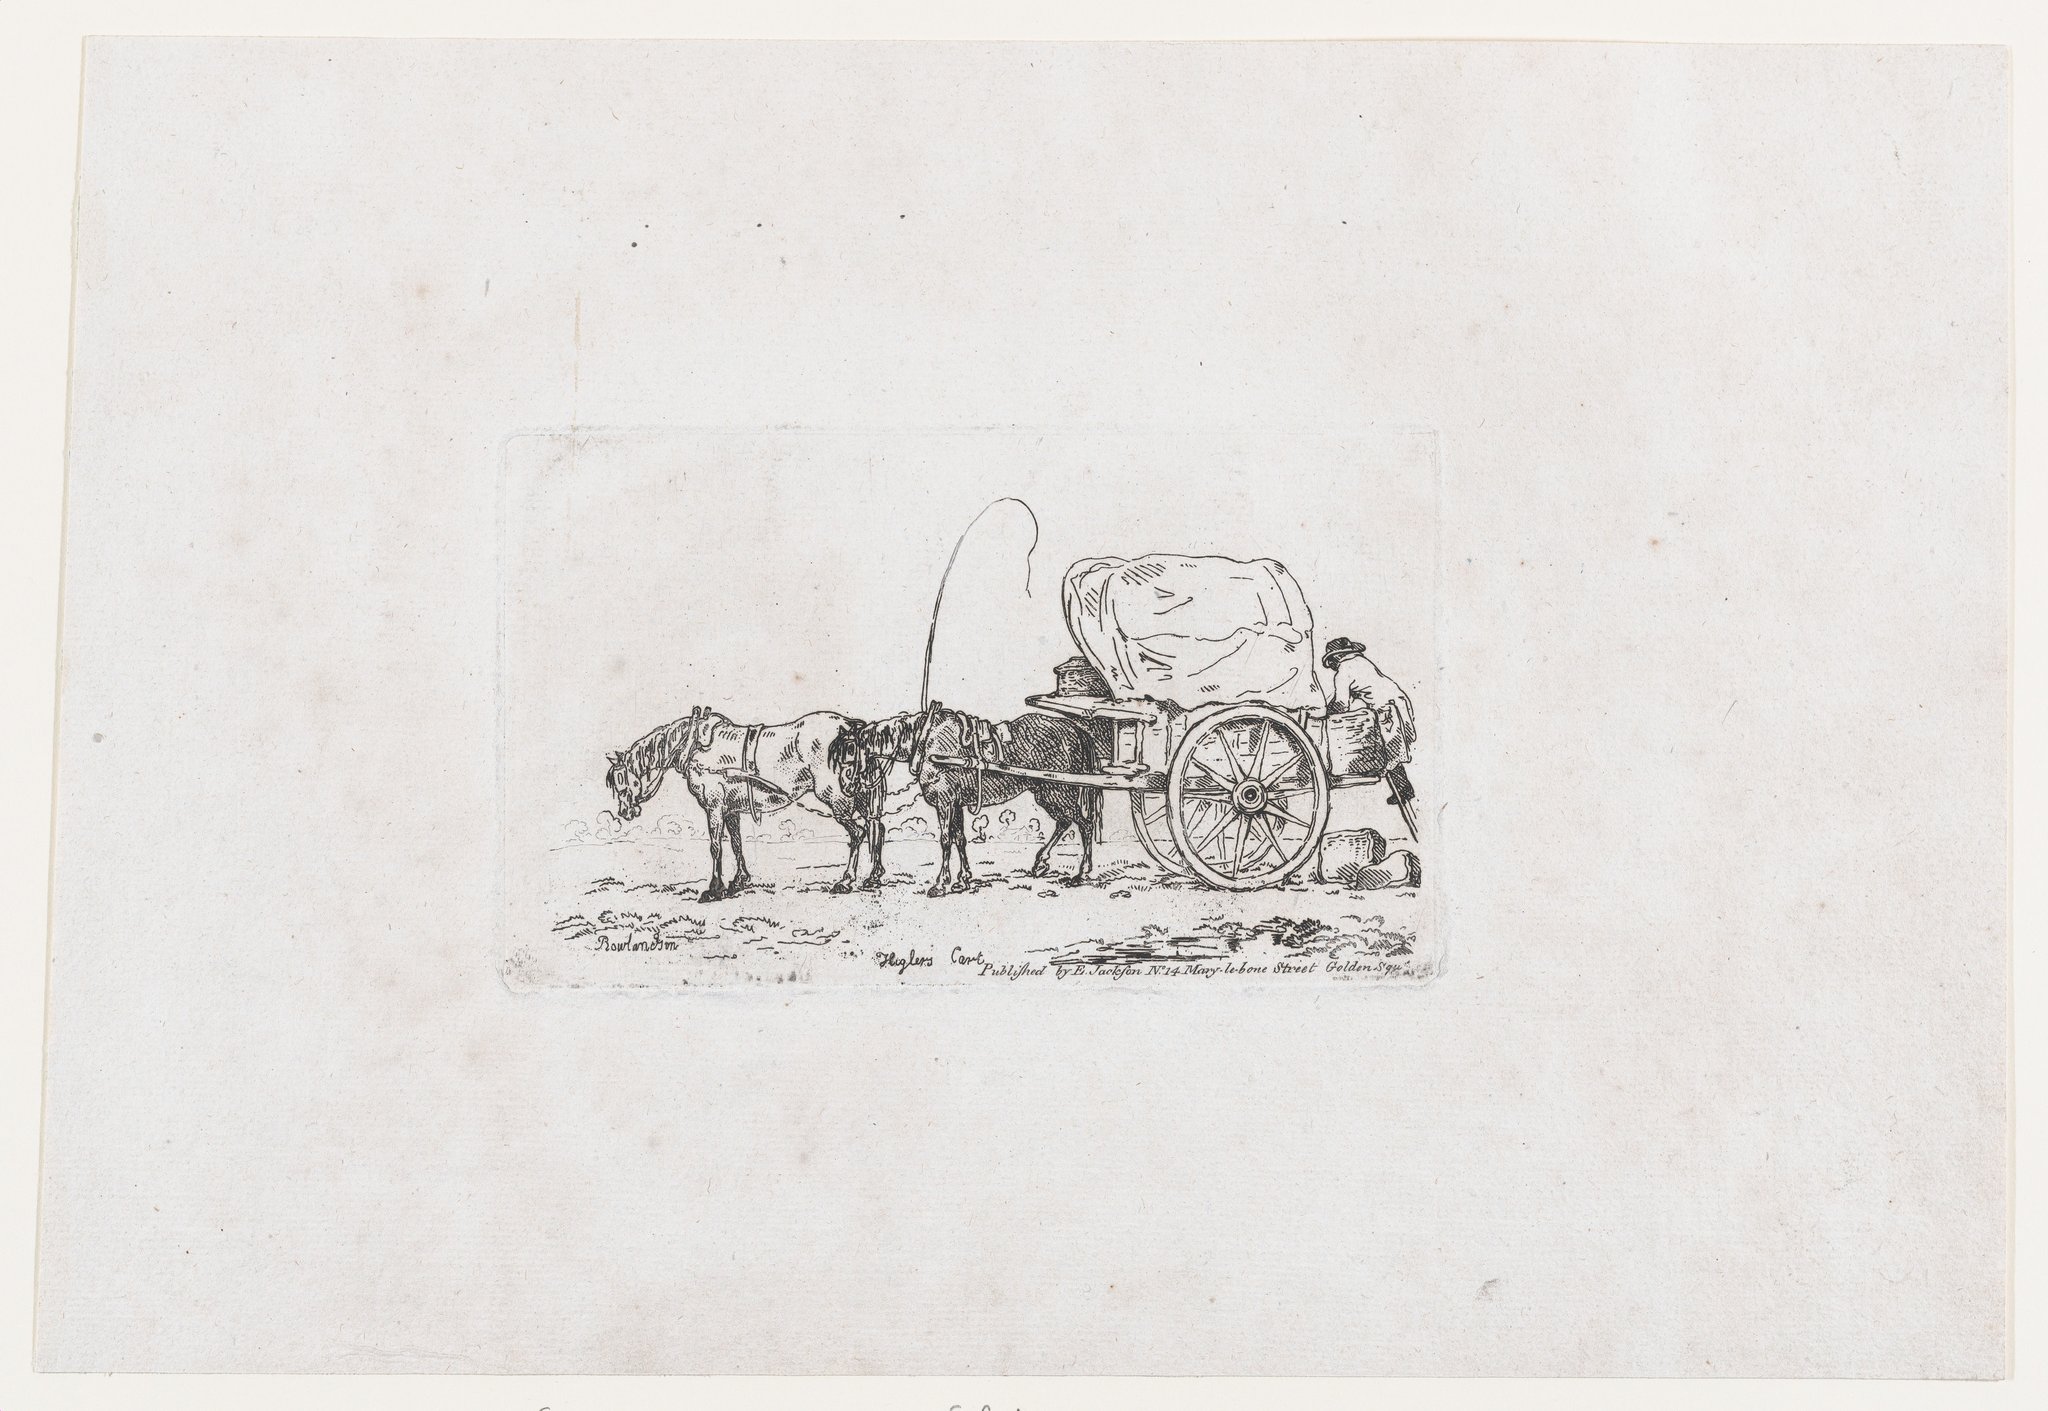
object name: print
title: Higlers Cart, from The Rhedarium, or, A New Book of Horses and Carriages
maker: thomas rowlandson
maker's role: artist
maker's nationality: british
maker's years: 1757-1827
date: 1784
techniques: etching, stippling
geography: london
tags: horses,carts